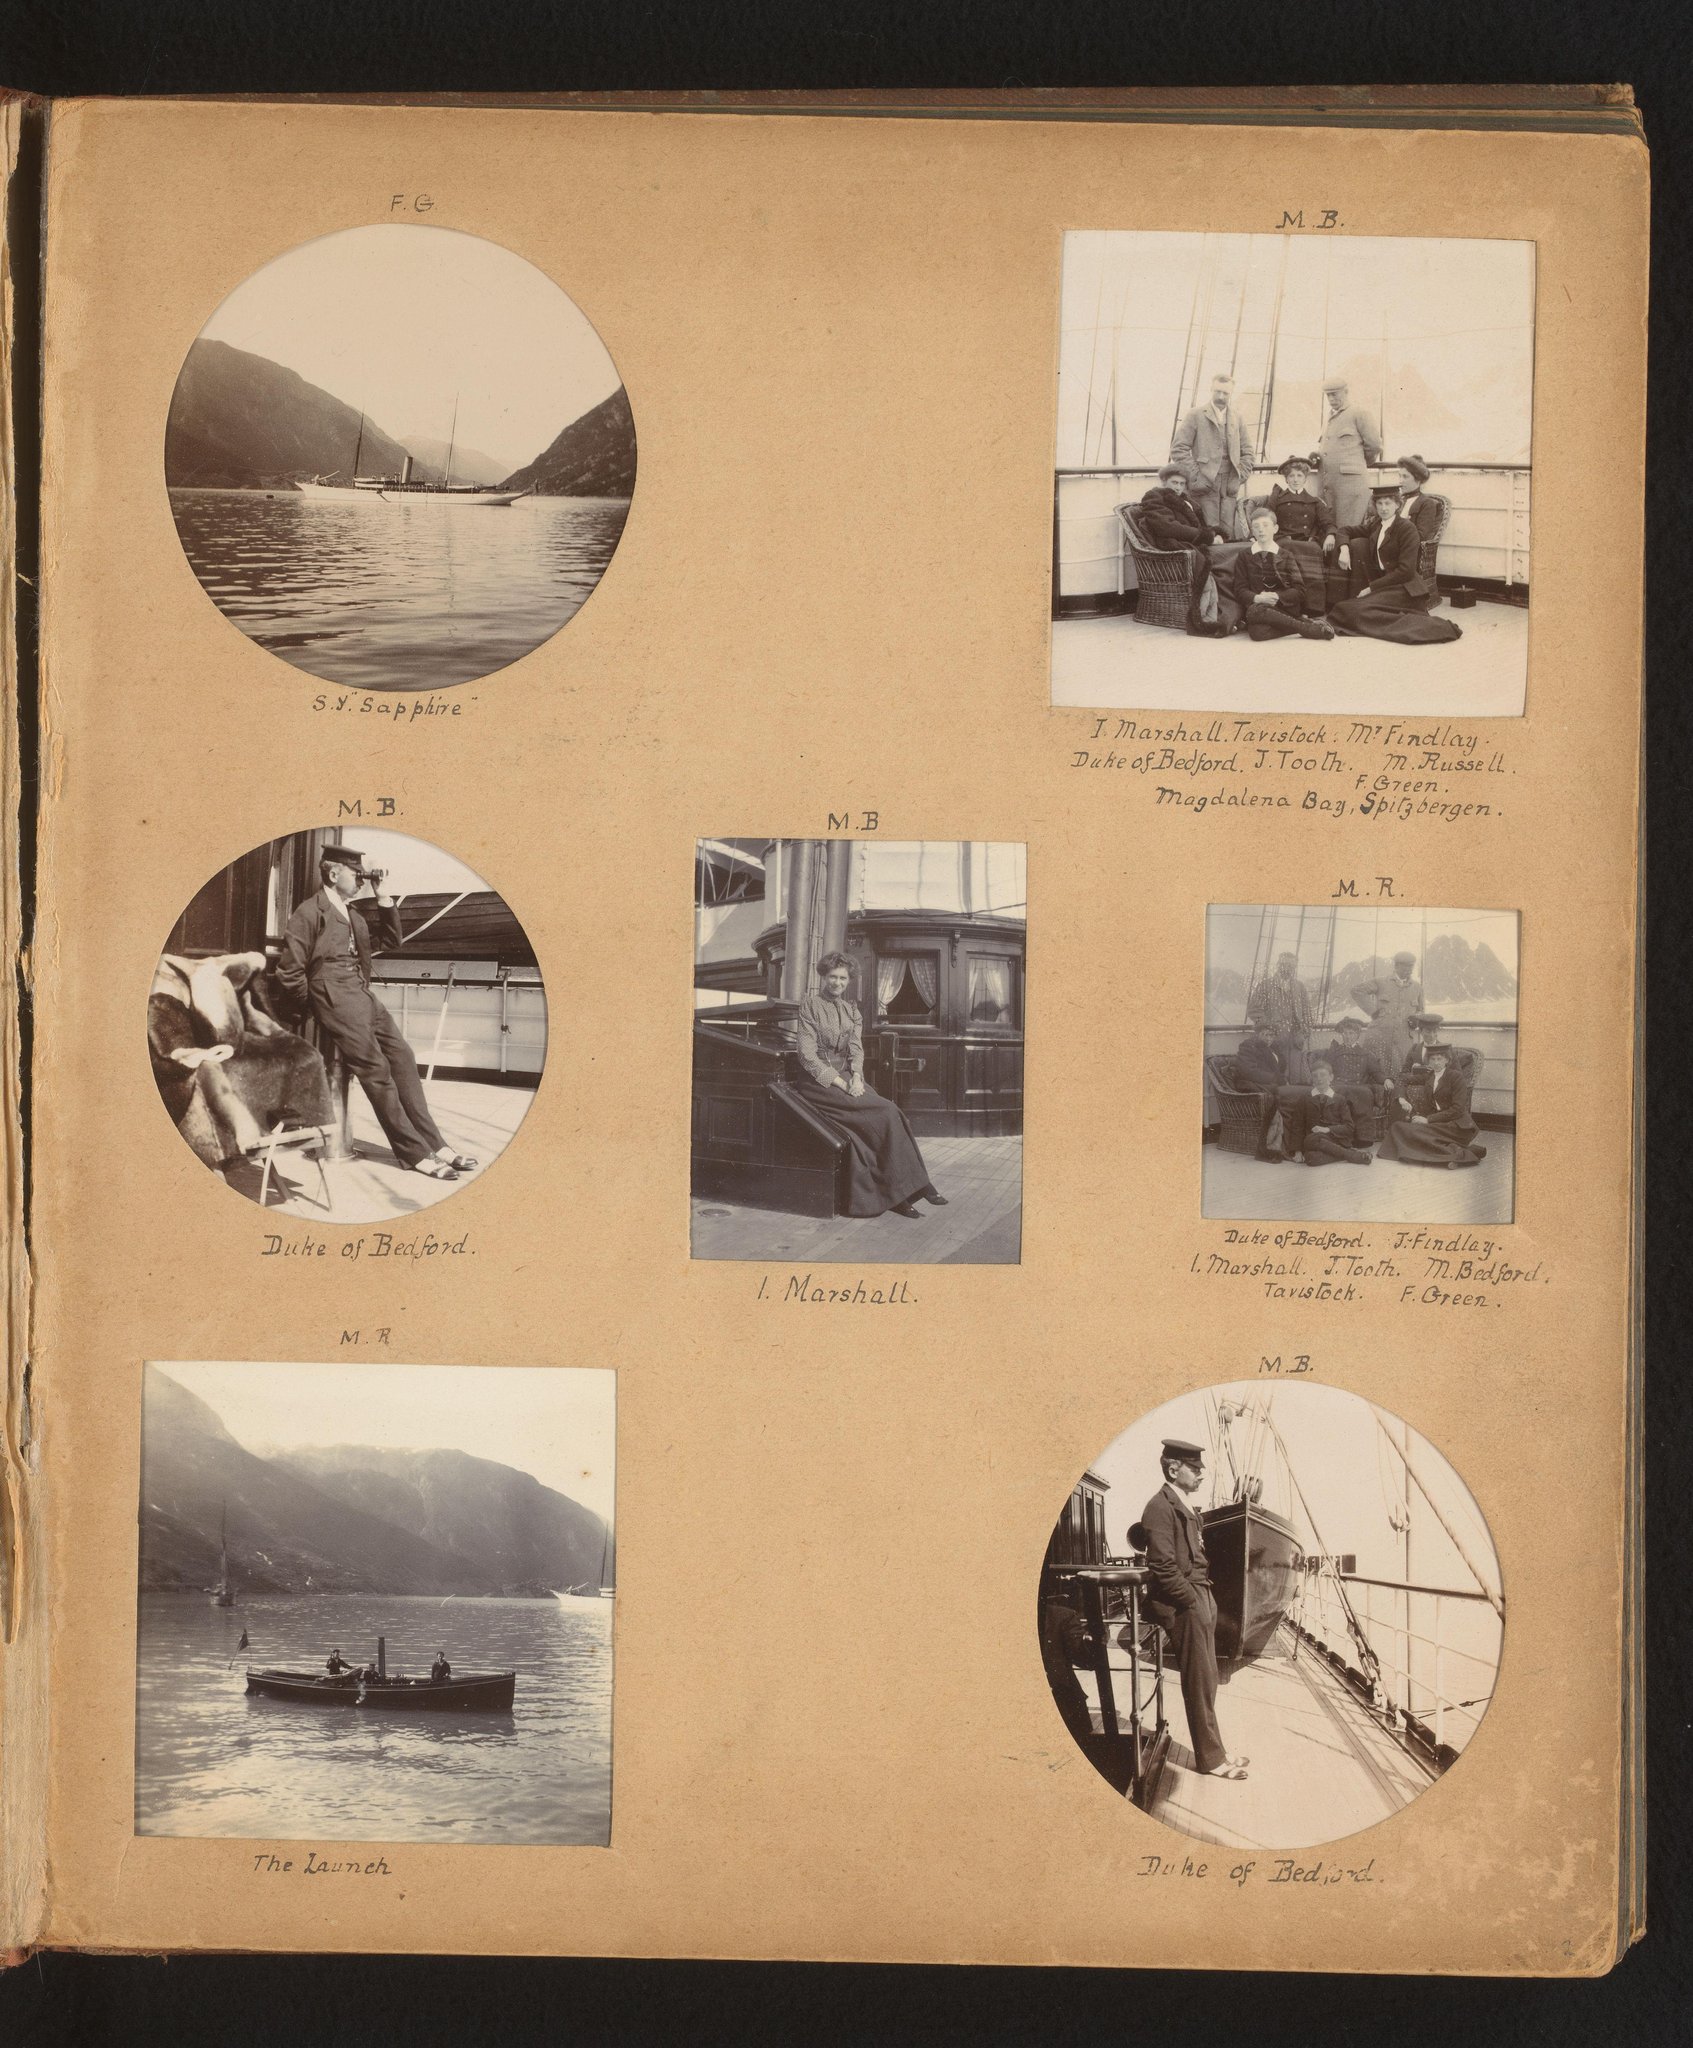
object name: album leaf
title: Zeven foto's van een reis met de S.Y. Sapphire naar Spitsbergen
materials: paper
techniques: gelatin silver print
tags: j. tooth, f. green (fotograaf), mary russell, politician, gulf, bay, passengers ~ ship, steamship, motorship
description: Deze foto's maken deel uit van een album.